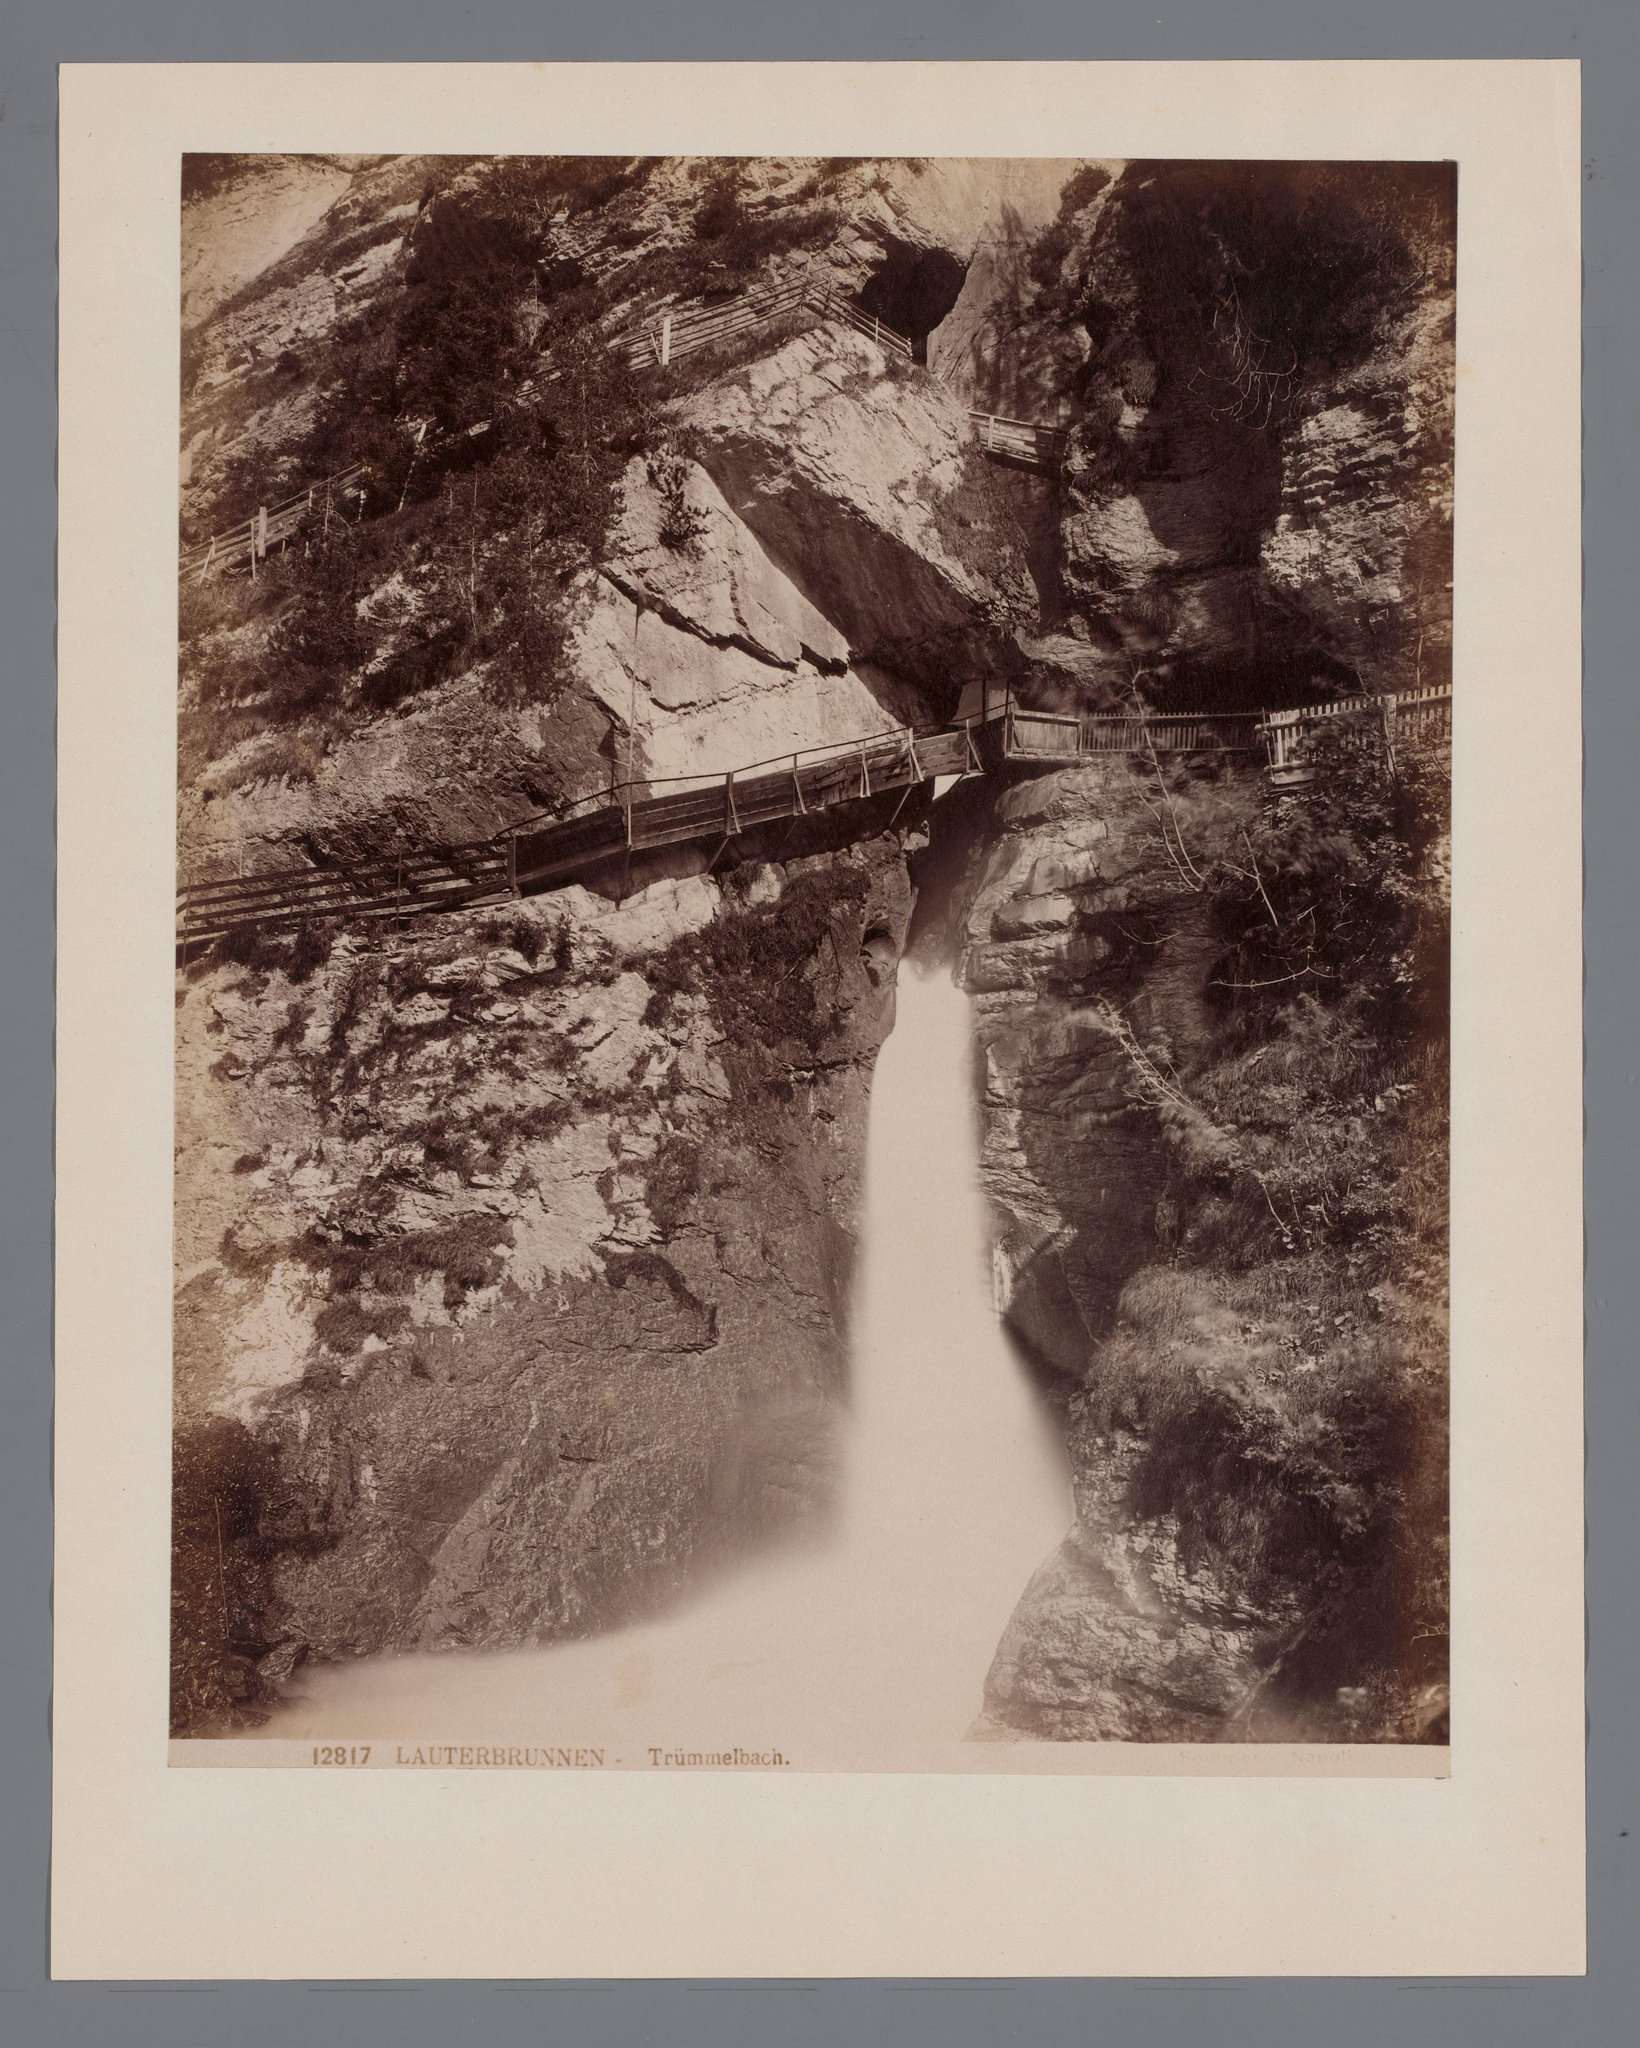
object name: photograph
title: Lauterbrunnen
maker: giorgio sommer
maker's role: fotograaf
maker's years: 1834-1914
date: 1857-1914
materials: cardboard, paper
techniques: albumen print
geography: lauterbrunnen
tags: waterfall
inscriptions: inscription: ‘nagekomen Diepr.’, number: ‘12817’